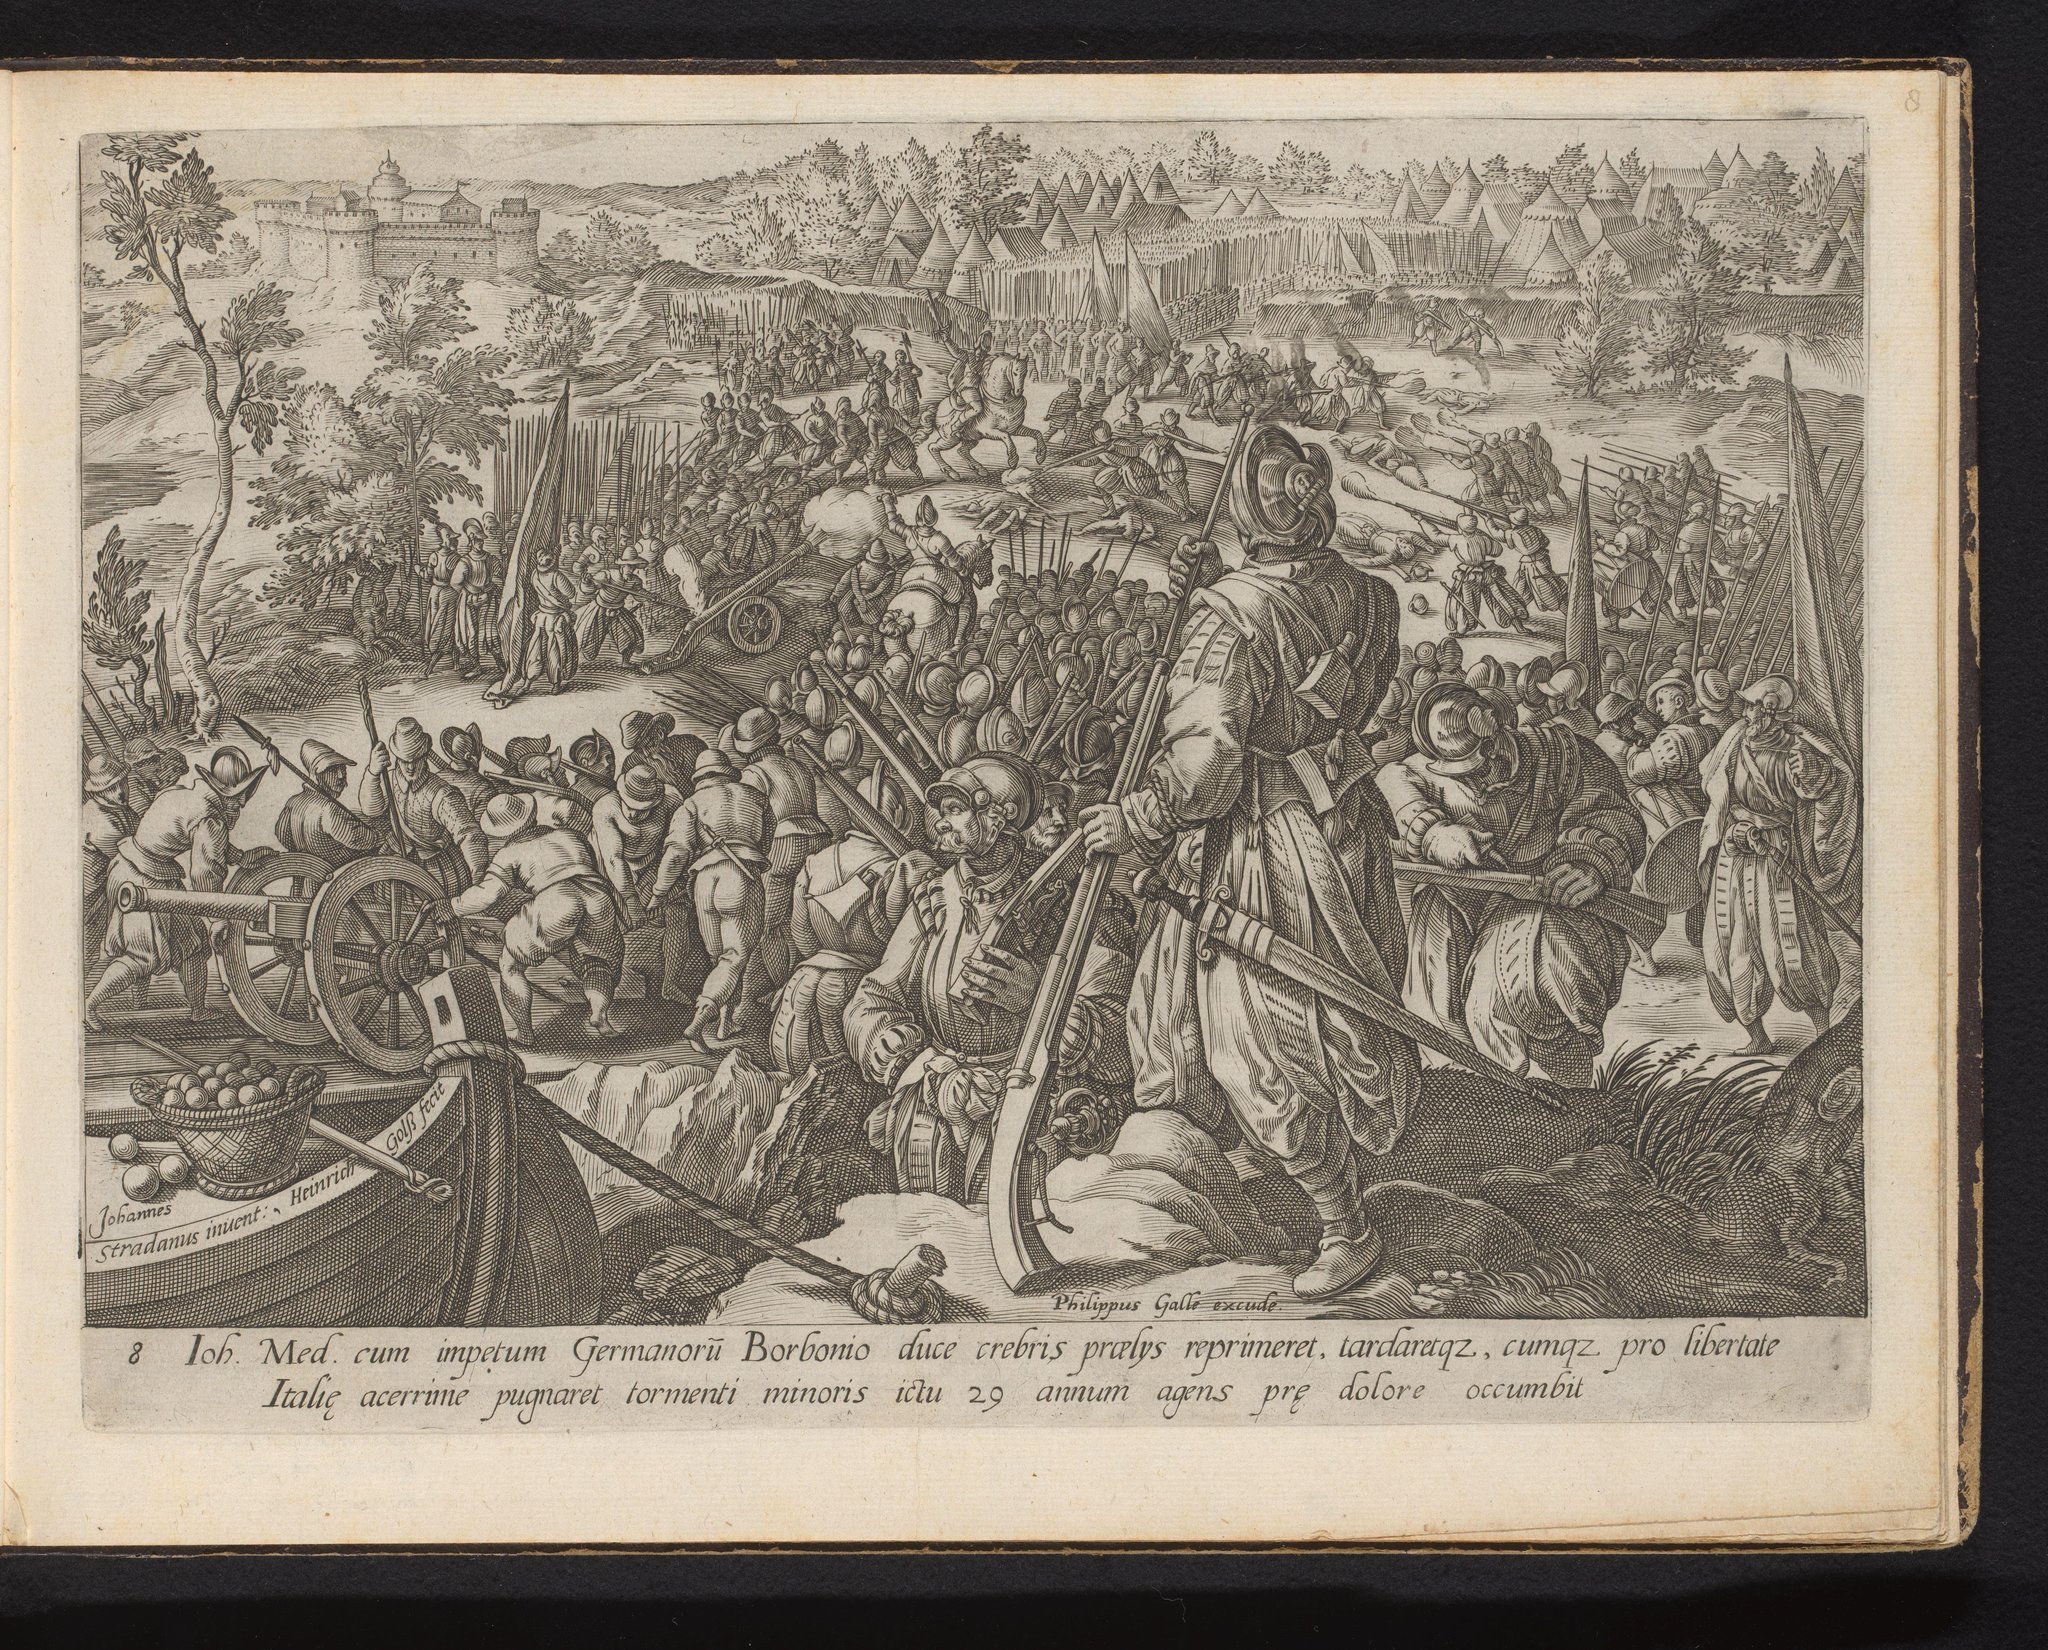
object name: album leaf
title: Familiegeschiedenis van het geslacht de' Medici (deel 1)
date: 1583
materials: paper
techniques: engraving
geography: antwerp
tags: violent death by weapon, weapons for striking a blow, battle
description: De dood van Giovanni de' Medici op de vlakte van Governolo. Op de voorgrond staat een soldaat met een musket. Hij kijkt uit over het gevecht op de achtergrond. Daar worden Giovanni de' Medici, zittend op zijn paard, en zijn mannen beschoten. Een falconet wordt op hen afgevuurd. Links op de voorgrond wordt een ander kanon van een boot geladen. In de ondermarge twee regels tekst in het Latijn en genummerd 8. De prent maakt deel uit van een album.